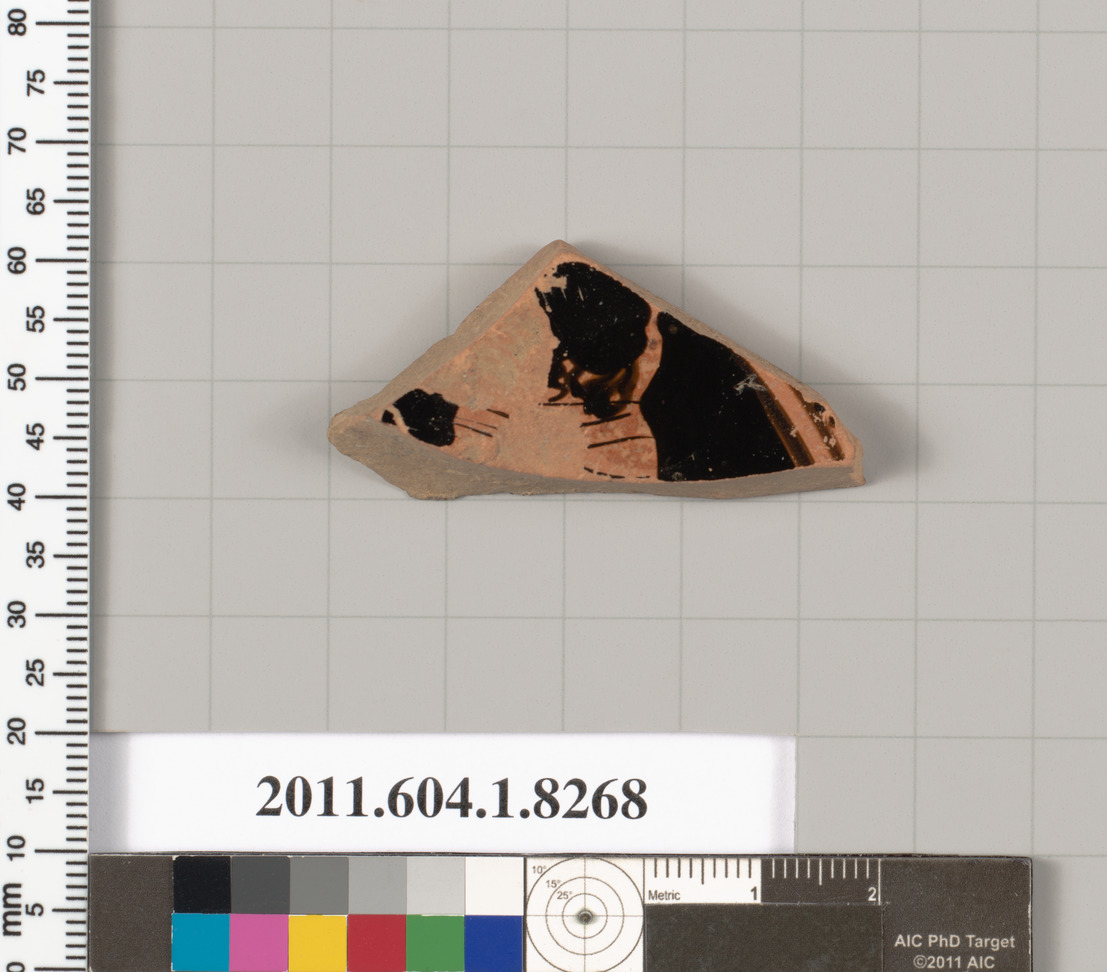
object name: kylix fragment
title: Terracotta fragment of a kylix (drinking cup)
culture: greek, attic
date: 434-368 BCE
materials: terracotta